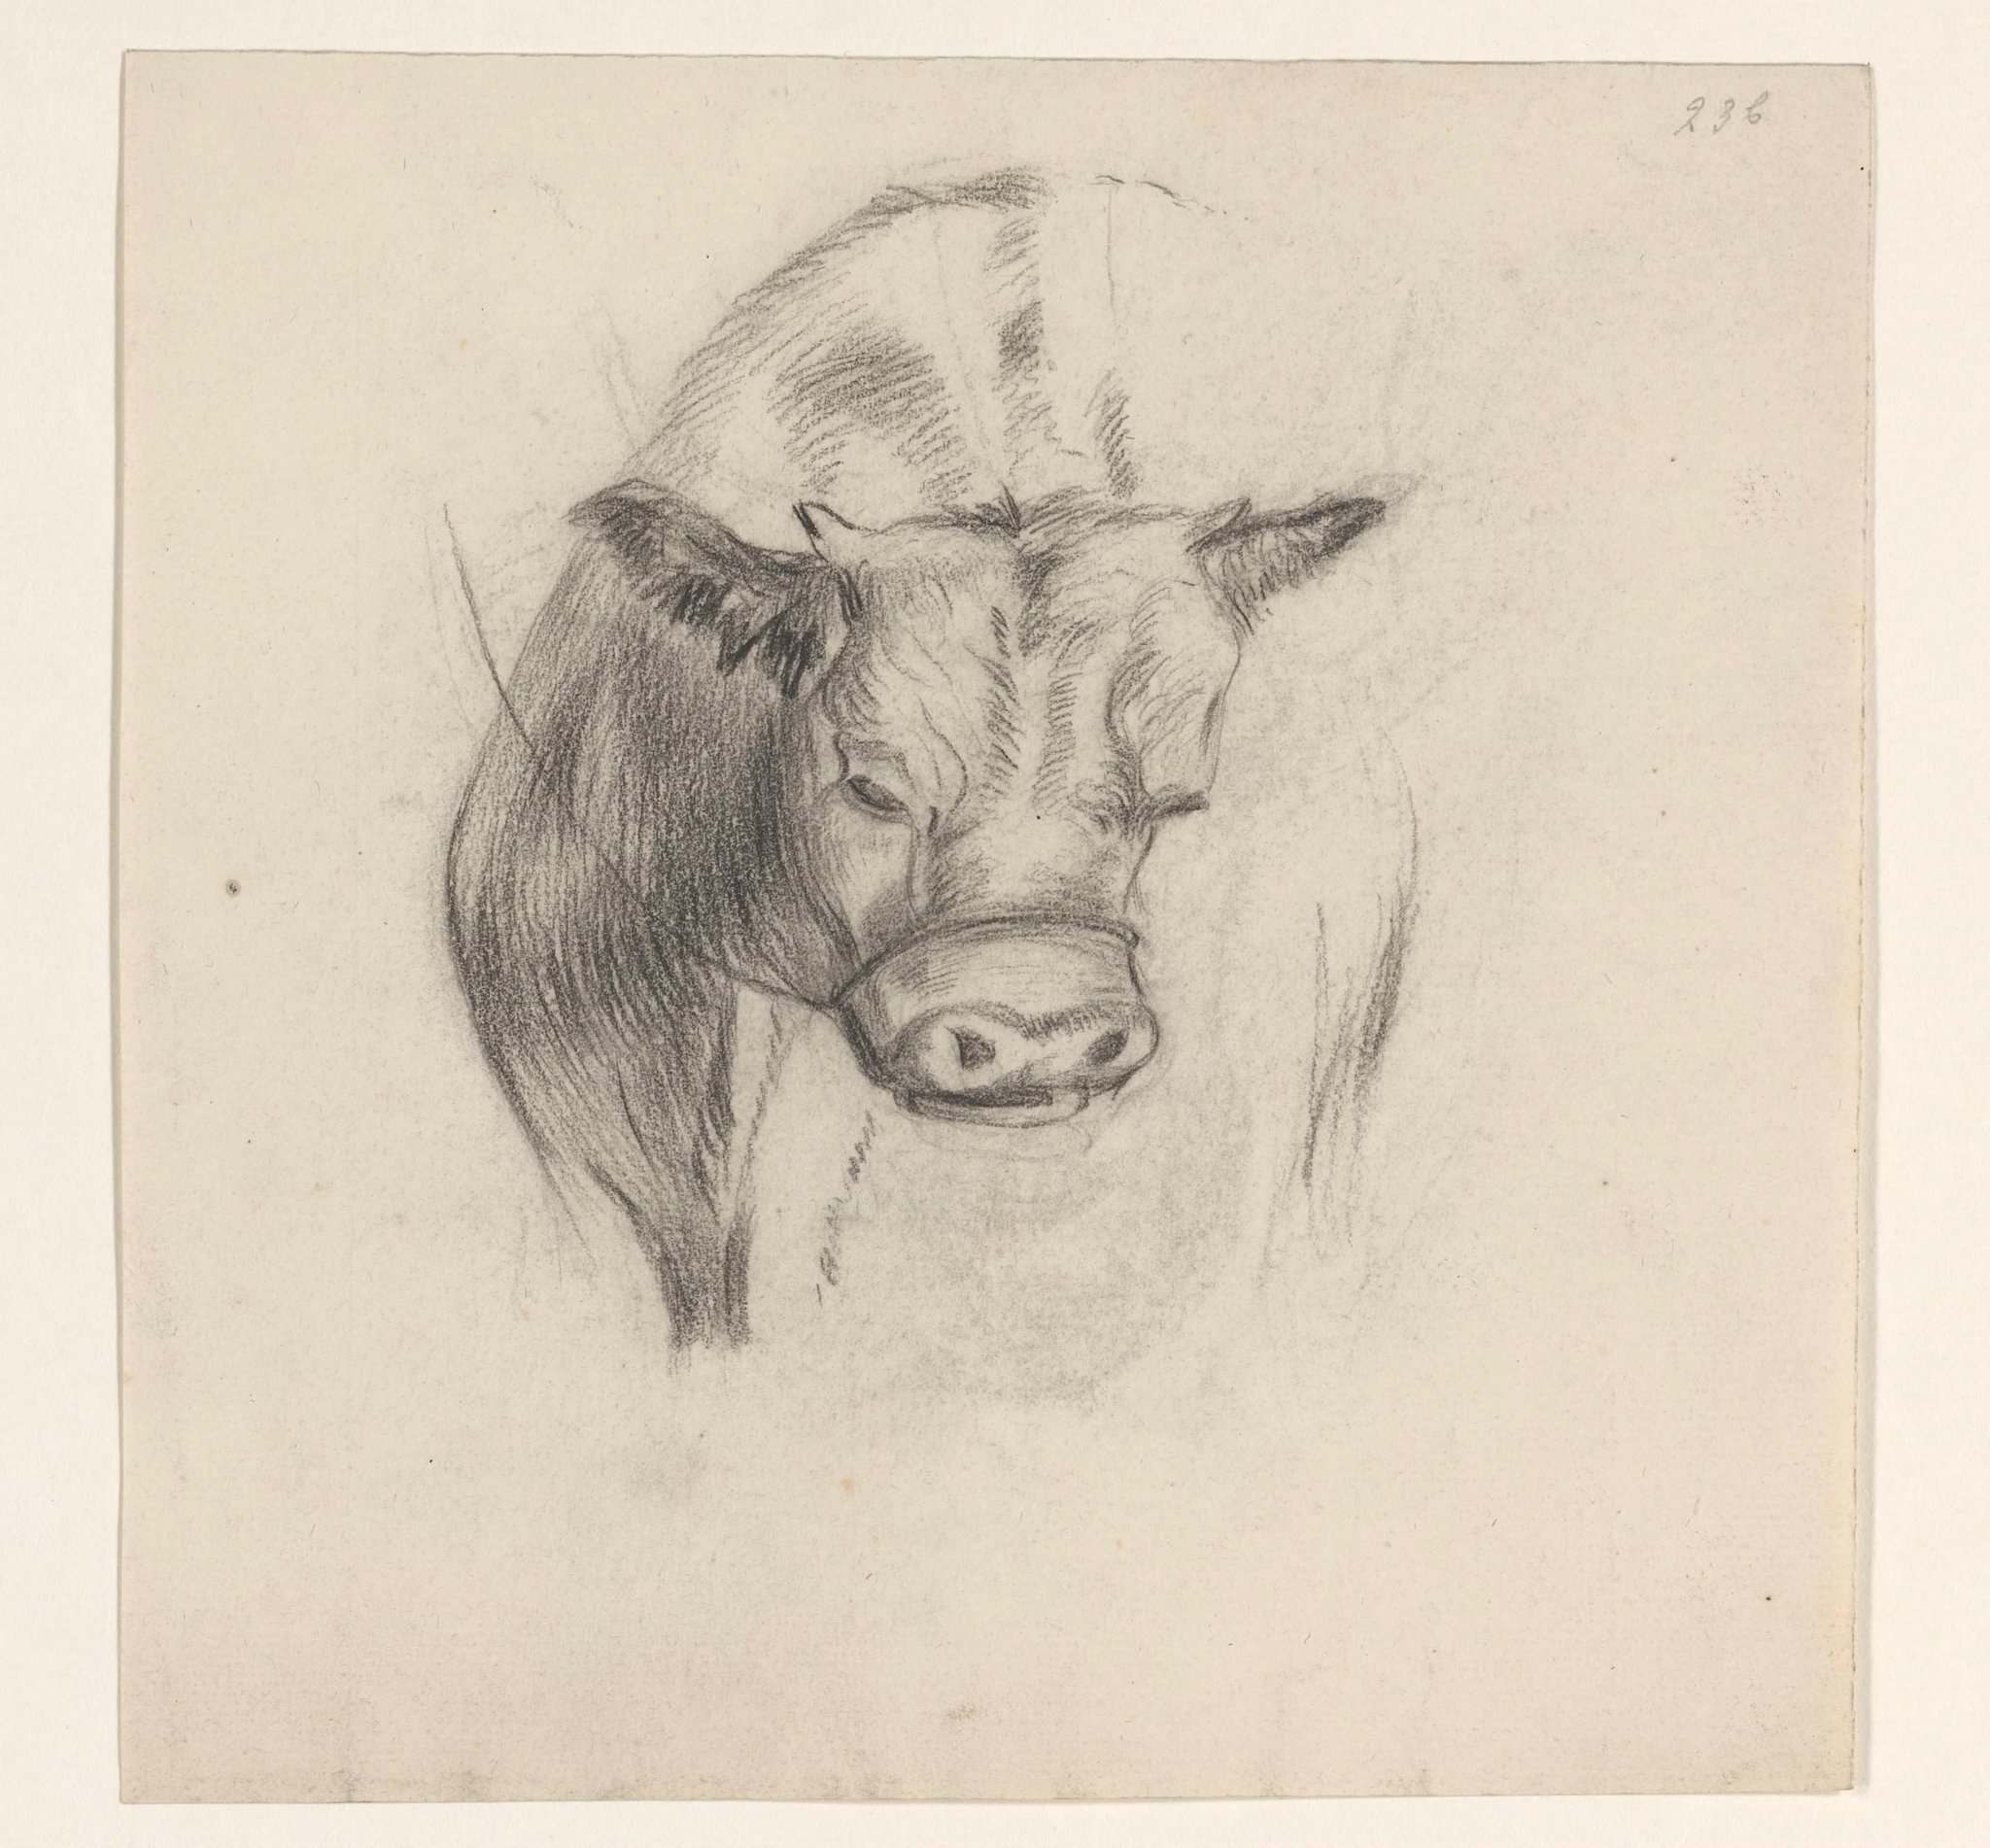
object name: drawing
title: Koe, van voren gezien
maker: johannes tavenraat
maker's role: draughtsman, painter, print maker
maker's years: 1809-1881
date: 1819-1881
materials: chalk, paper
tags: cow